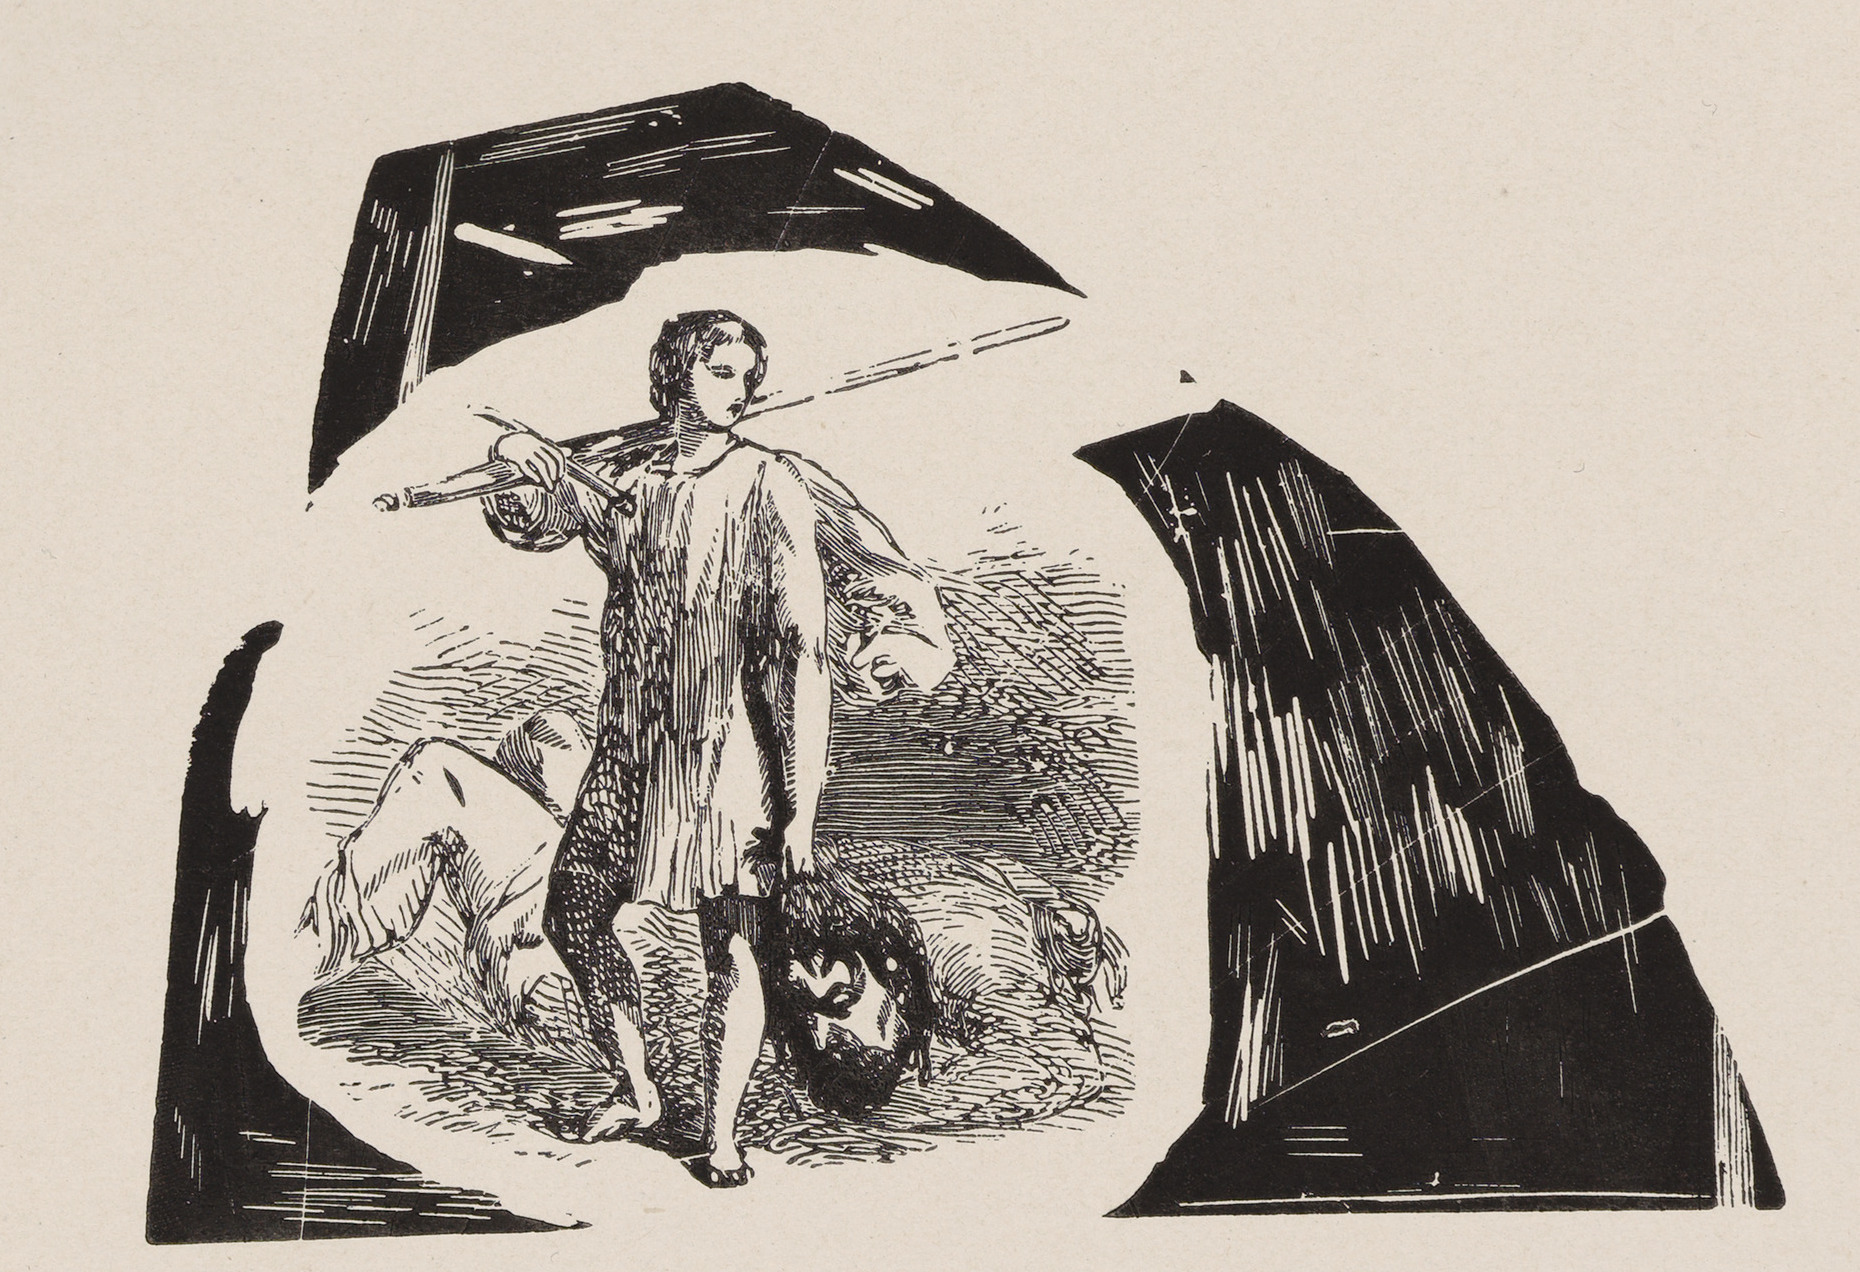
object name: print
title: David with the Head of Goliath / Grave Digger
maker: virginia granbery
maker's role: artist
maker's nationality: american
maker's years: 1831-1921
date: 1857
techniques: engraving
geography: united states